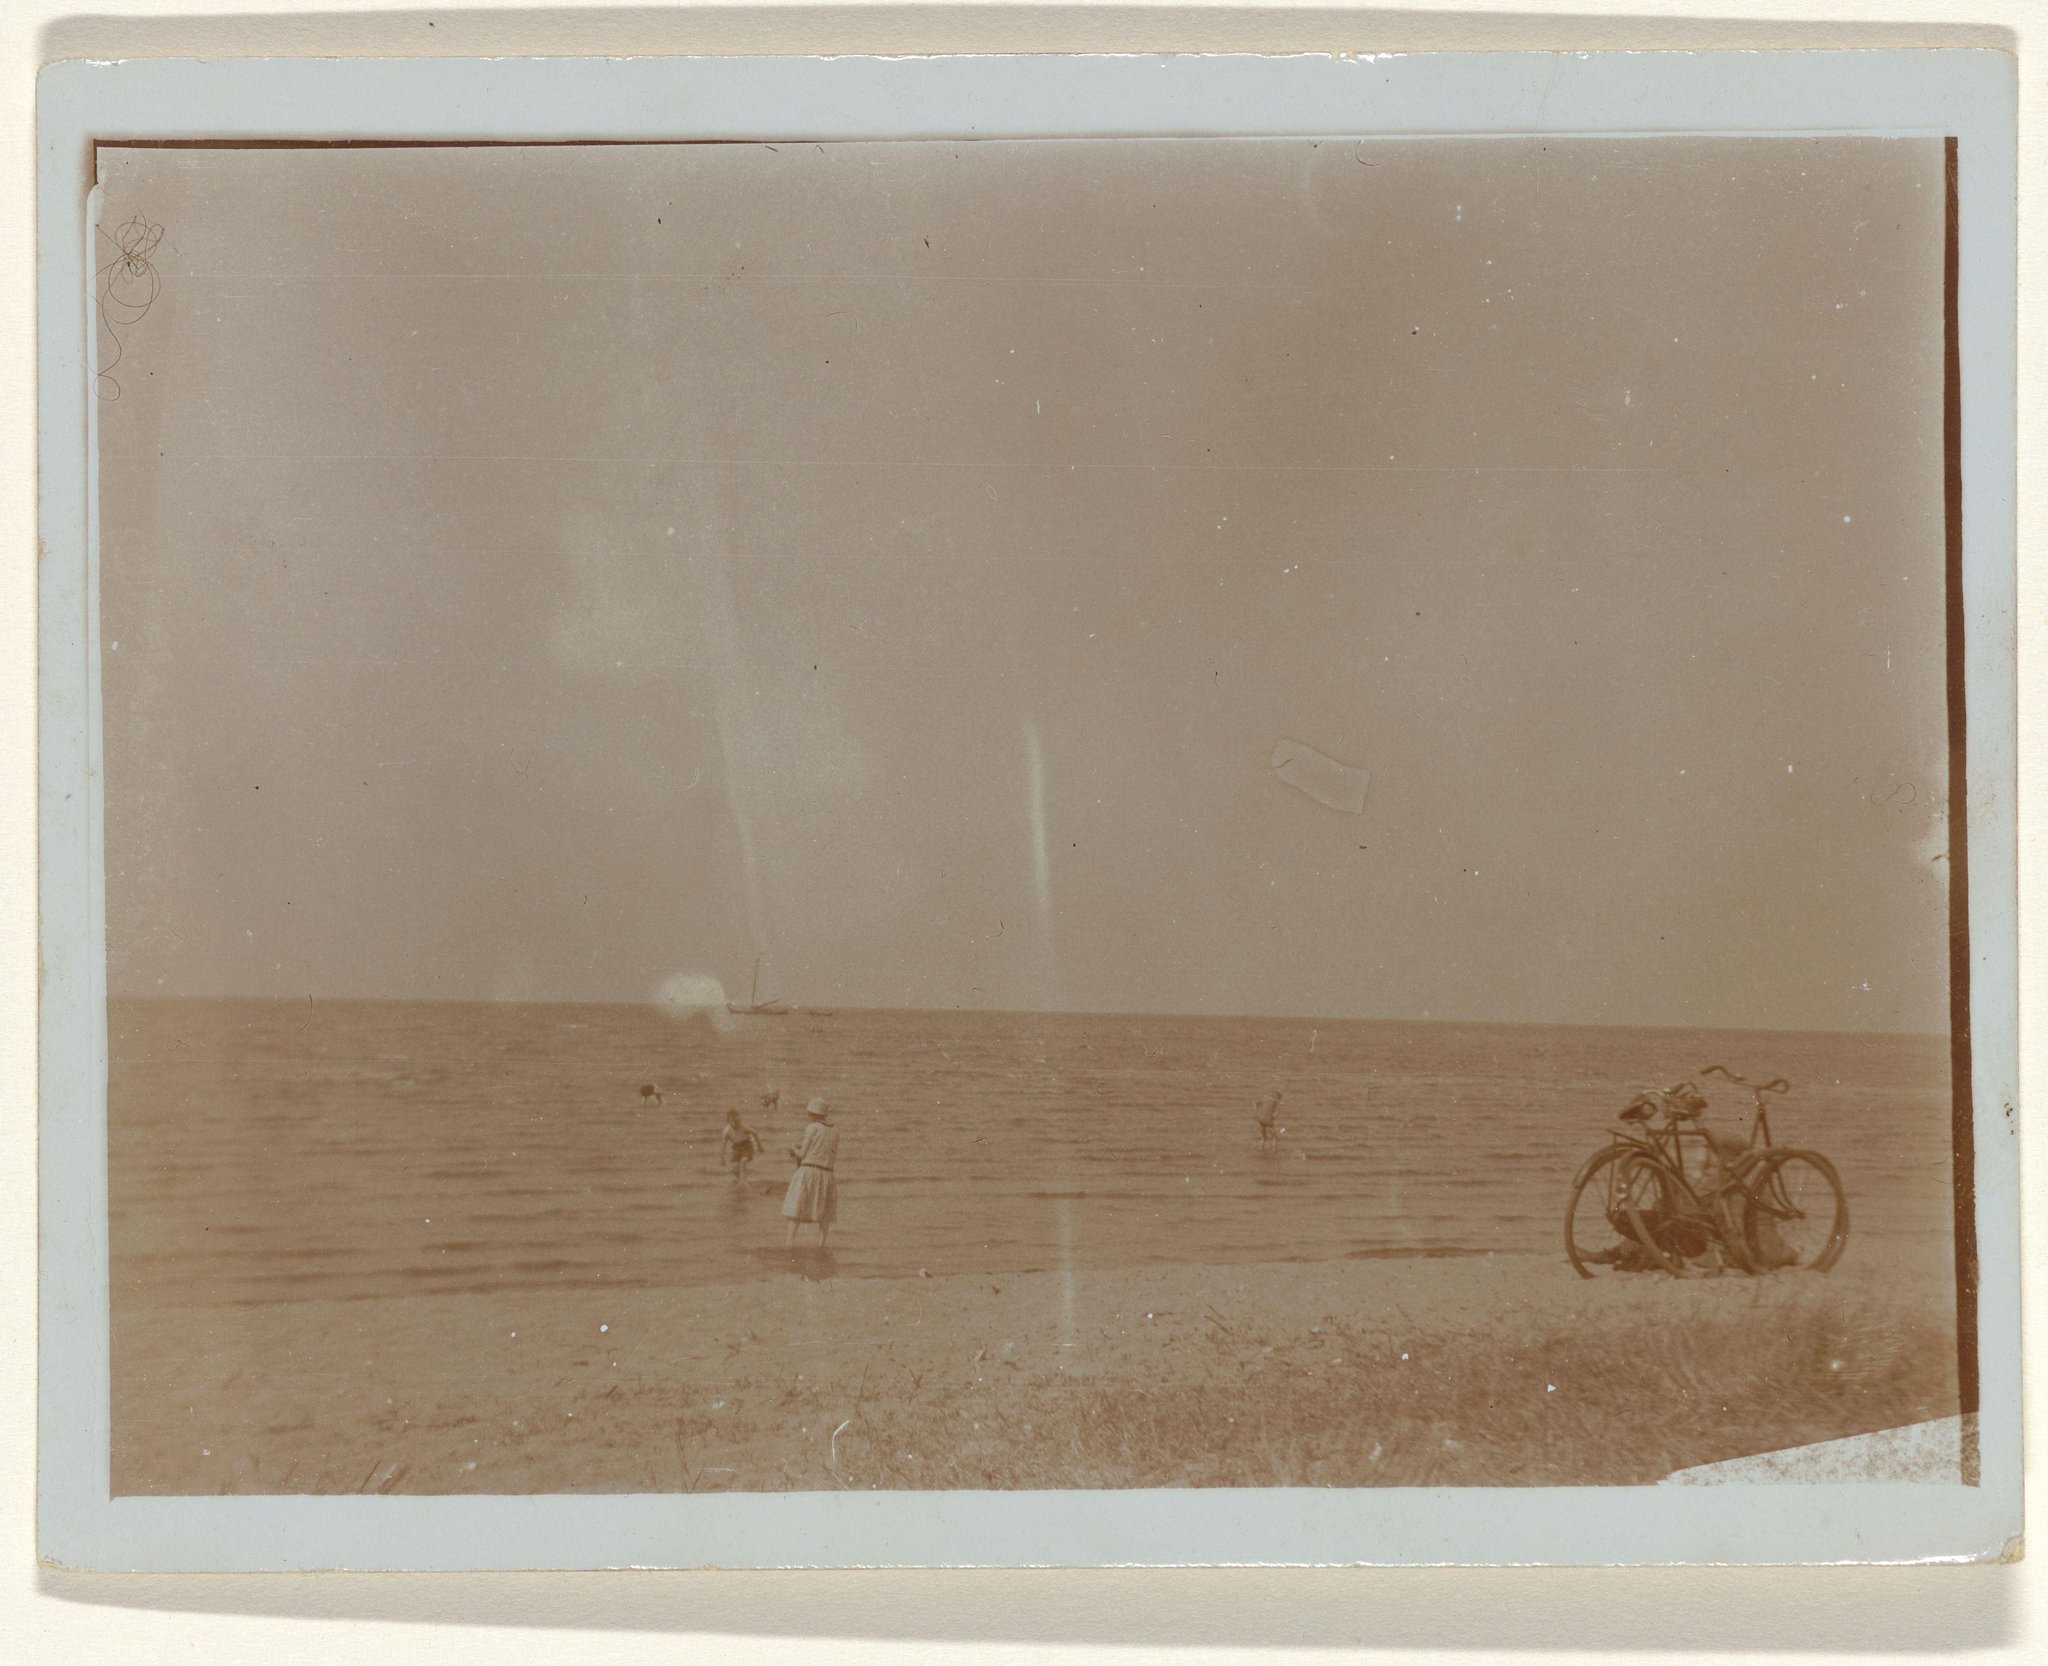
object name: photograph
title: Strand bij Valkeveen met pootjebadende mensen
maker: Anonymous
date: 1925-1930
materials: paper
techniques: collodion silver print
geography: valkeveen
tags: beach (as place of recreation)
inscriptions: inscription: ‘N’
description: Strand bij Valkeveen met pootjebadende mensen. Op het stand zit een man met een fiets naast zich.